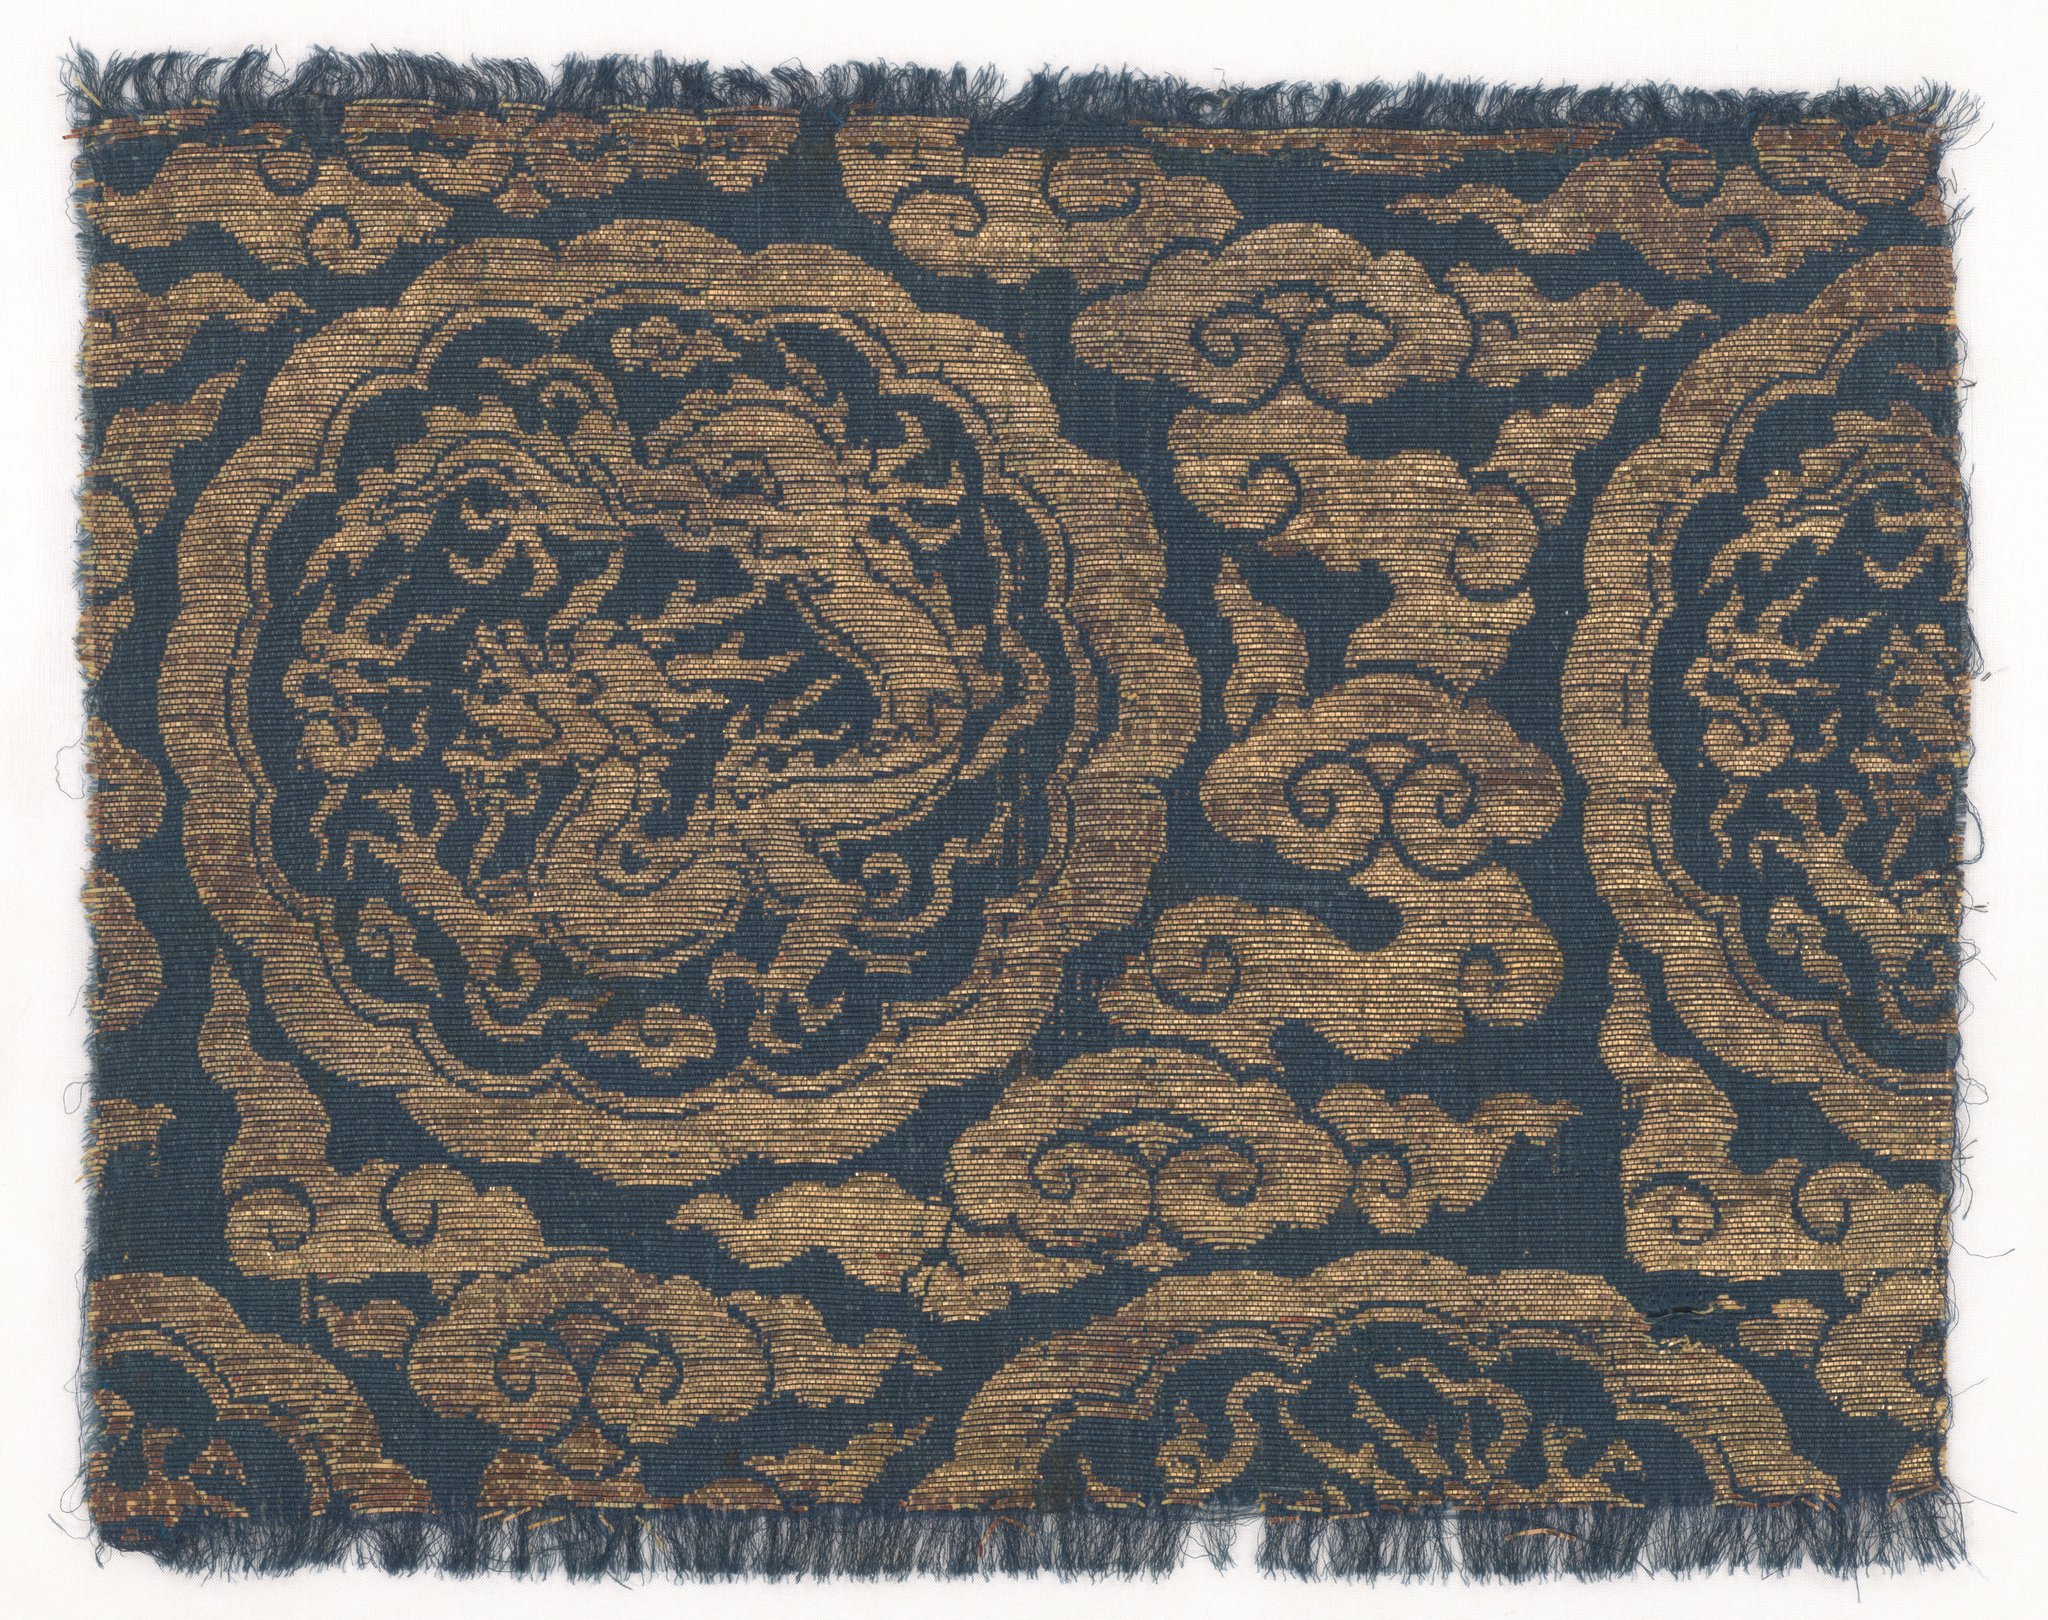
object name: fragment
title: Dragons chasing flaming pearls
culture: chinese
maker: unidentified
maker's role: artist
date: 1301-1400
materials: metal thread, silk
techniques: lampas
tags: dragons